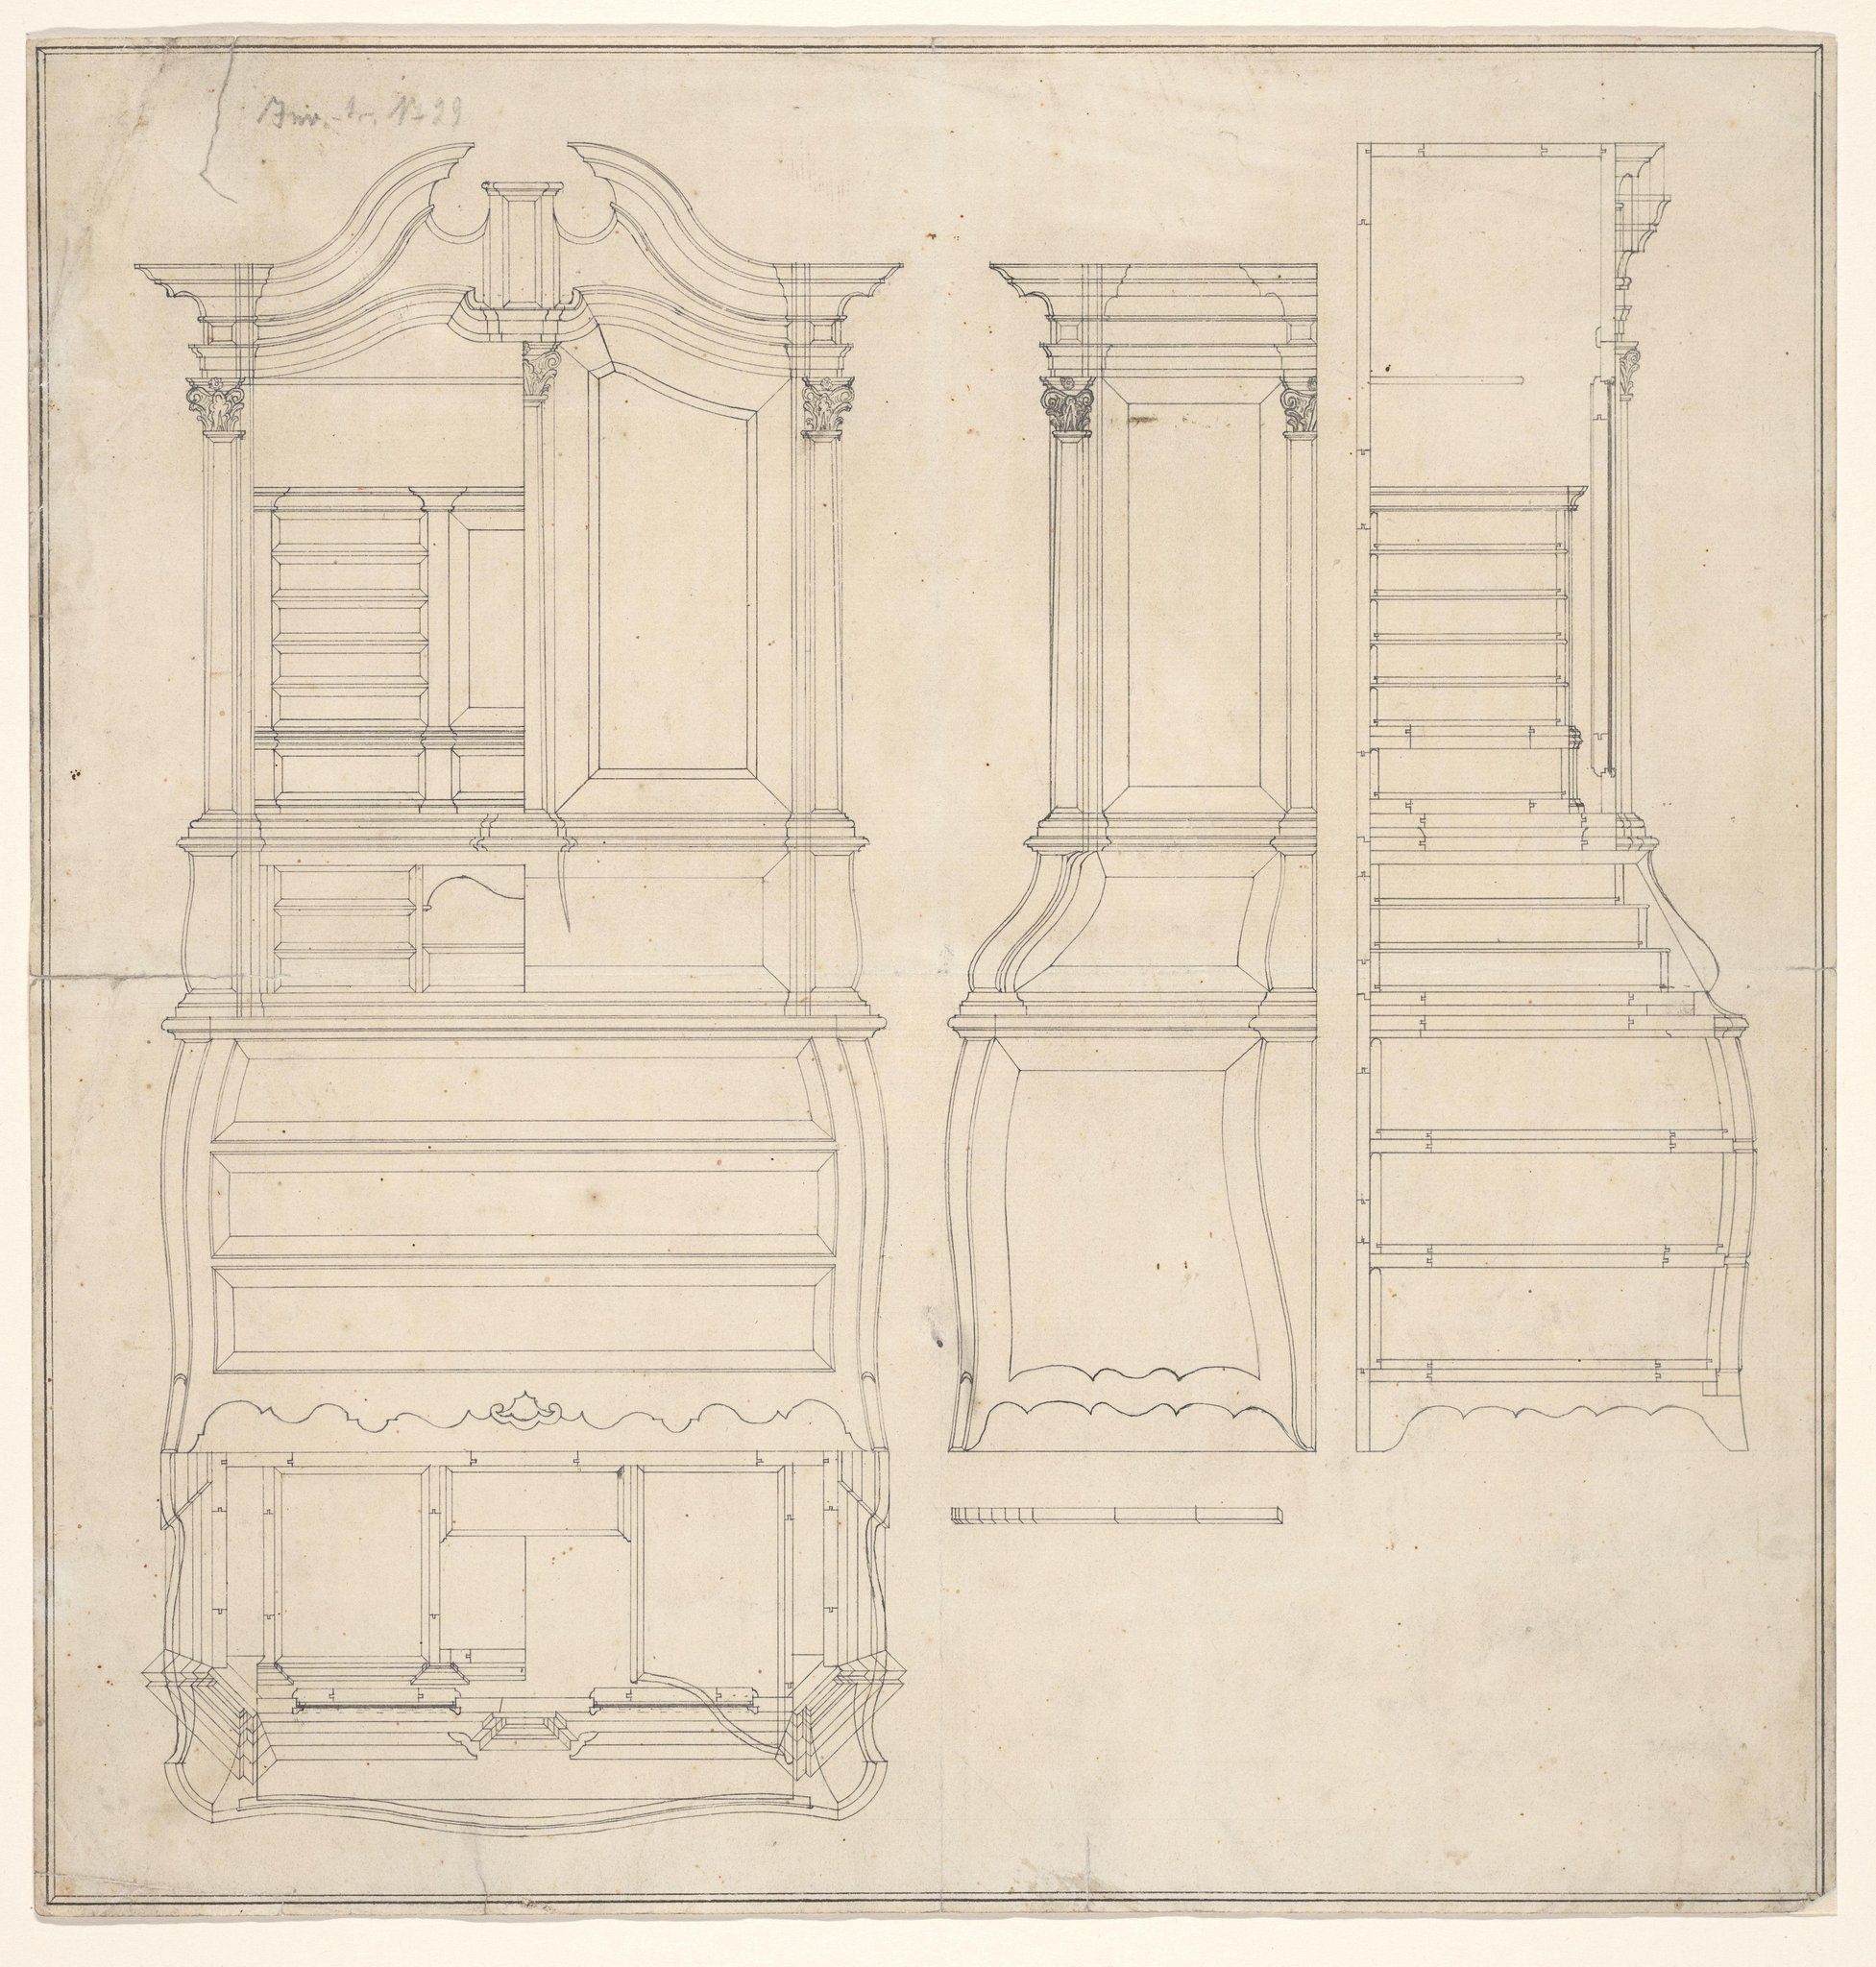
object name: design drawing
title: Ontwerp voor een schrijfmeubel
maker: Anonymous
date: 1770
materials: graphite, ink, paper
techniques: pen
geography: berlin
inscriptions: inscription: ‘Inv. Tr. [?] N. 29.’, watermark: ‘VDL’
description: Daaronder een plattegrond en rechts een zijaanzicht van rechts en een doorsnede vanaf de linkerzijde. Onder het zijaanzicht een maatstaf.